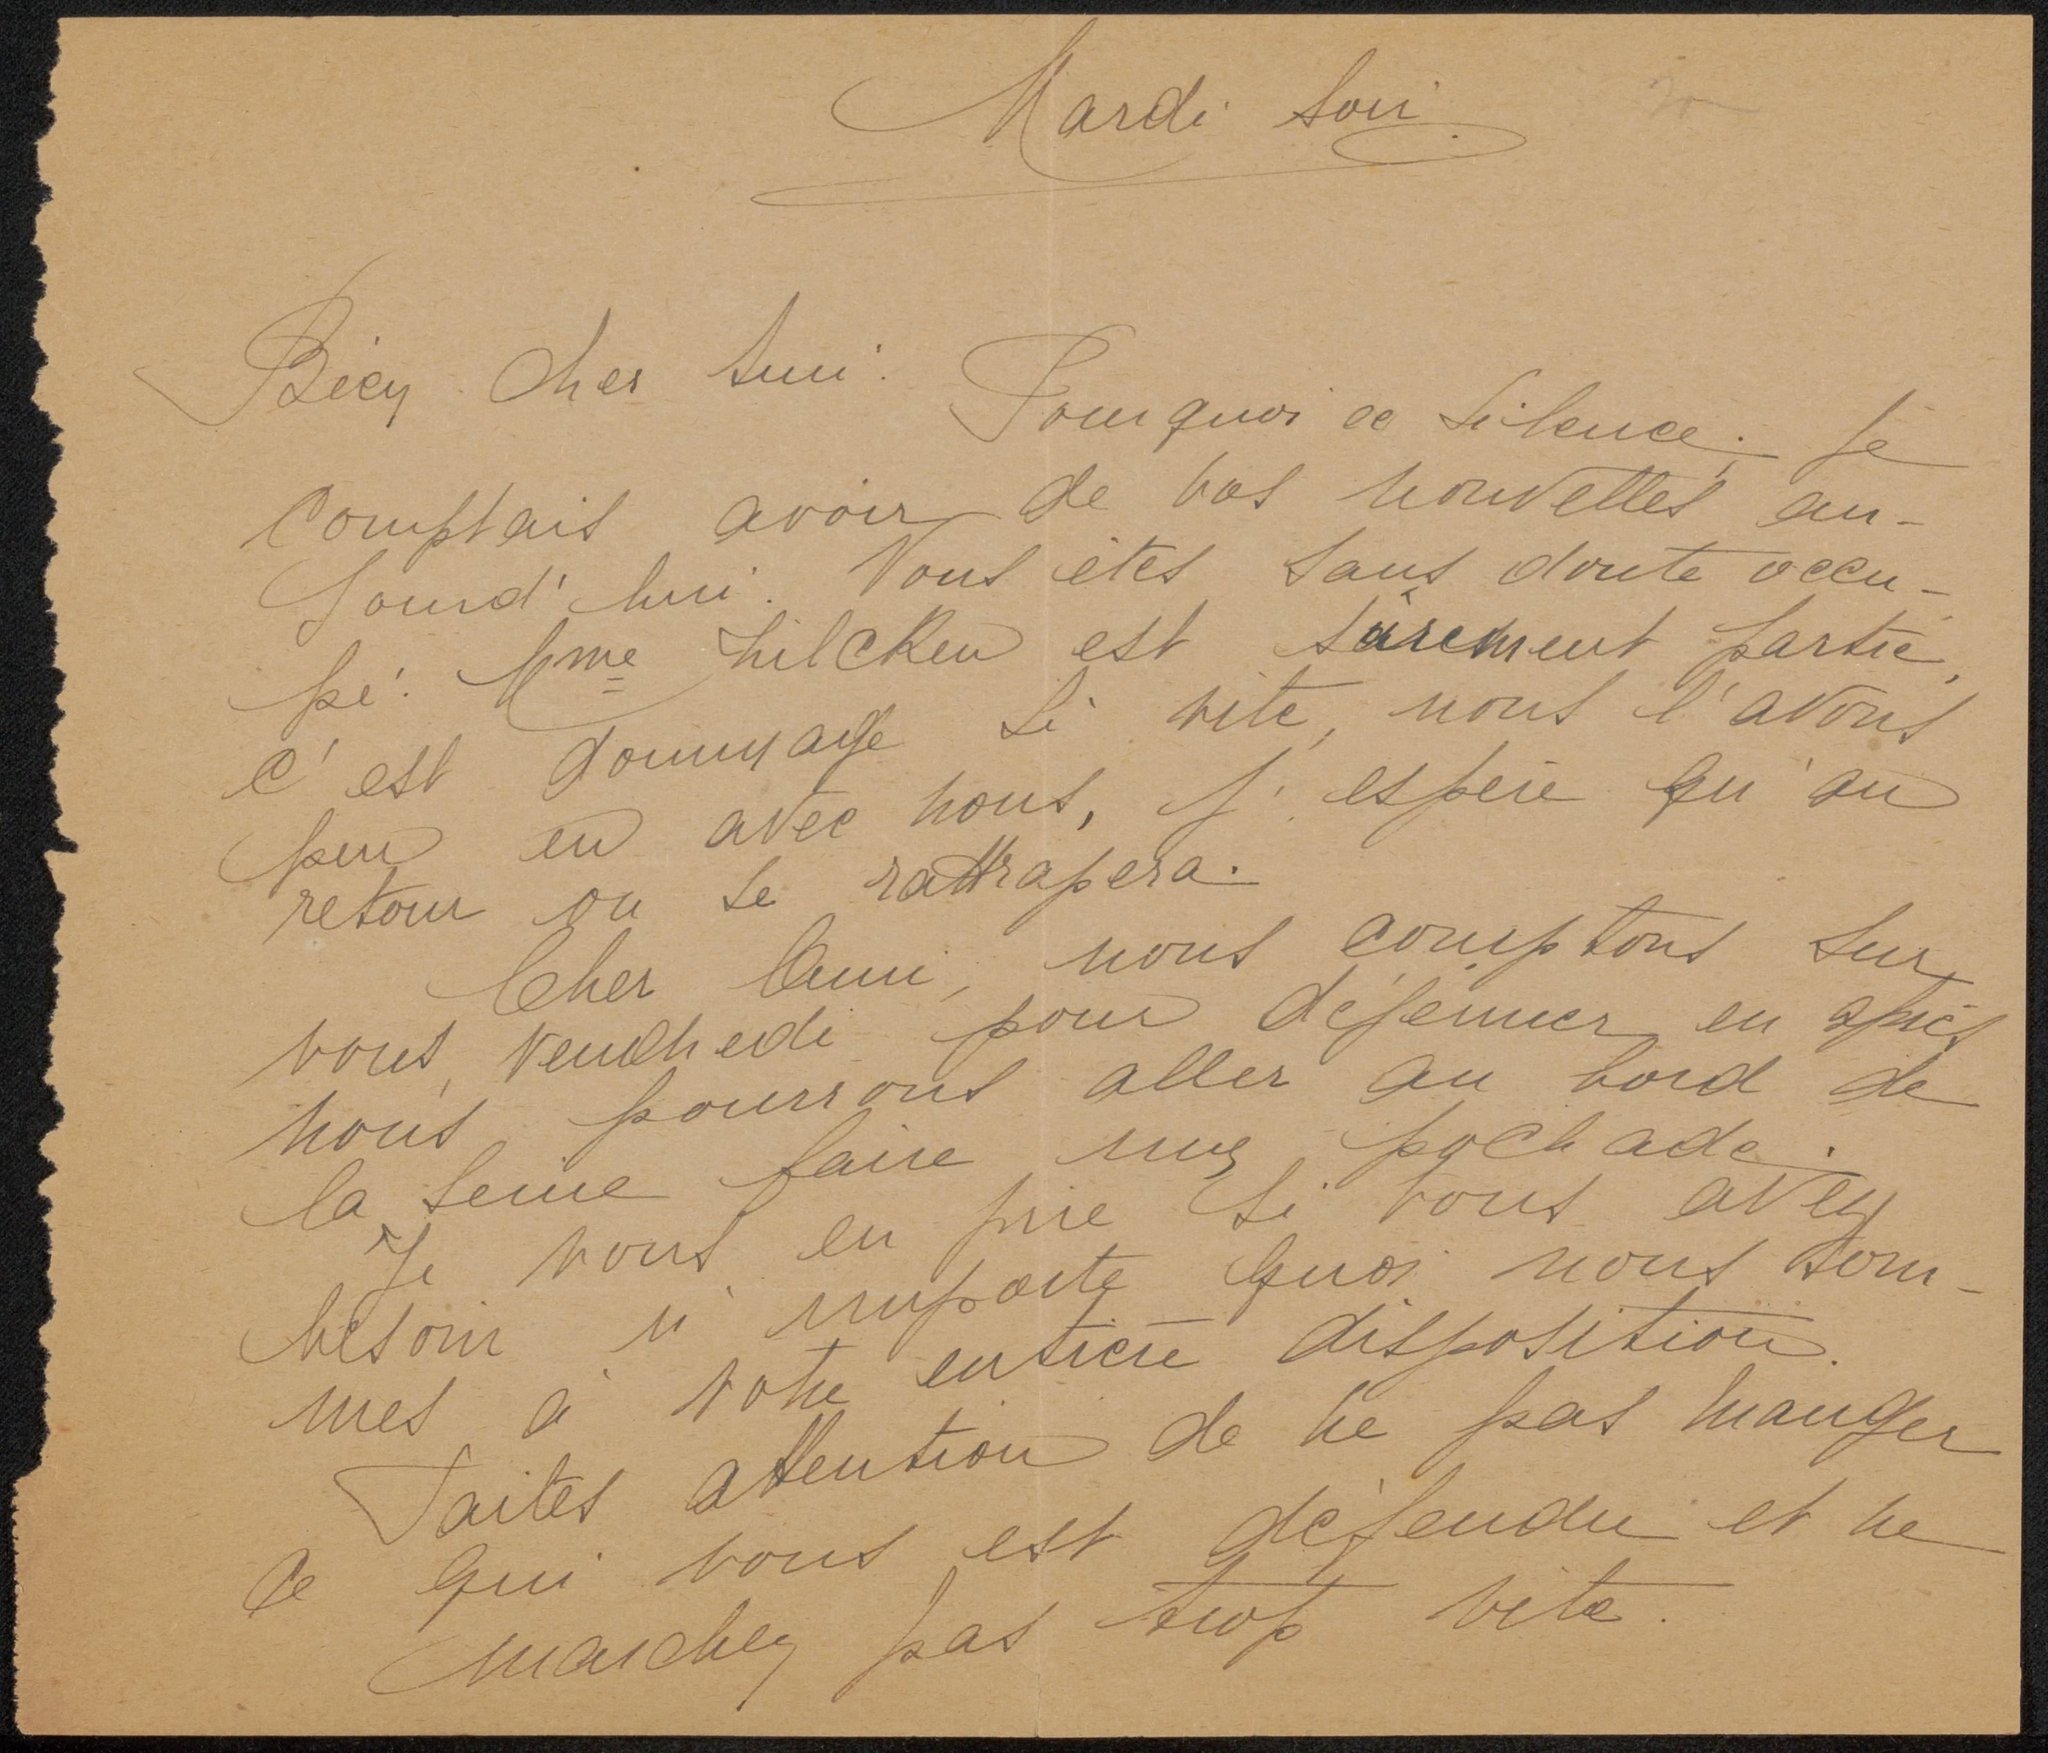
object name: letter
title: Brief aan Philip Zilcken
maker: rose imel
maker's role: draughtsman, painter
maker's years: 1901-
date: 1911-1930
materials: ink, paper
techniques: pen, writing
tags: the hague, painter, draughtsman, philip zilcken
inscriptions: collector's mark: ‘RPK’